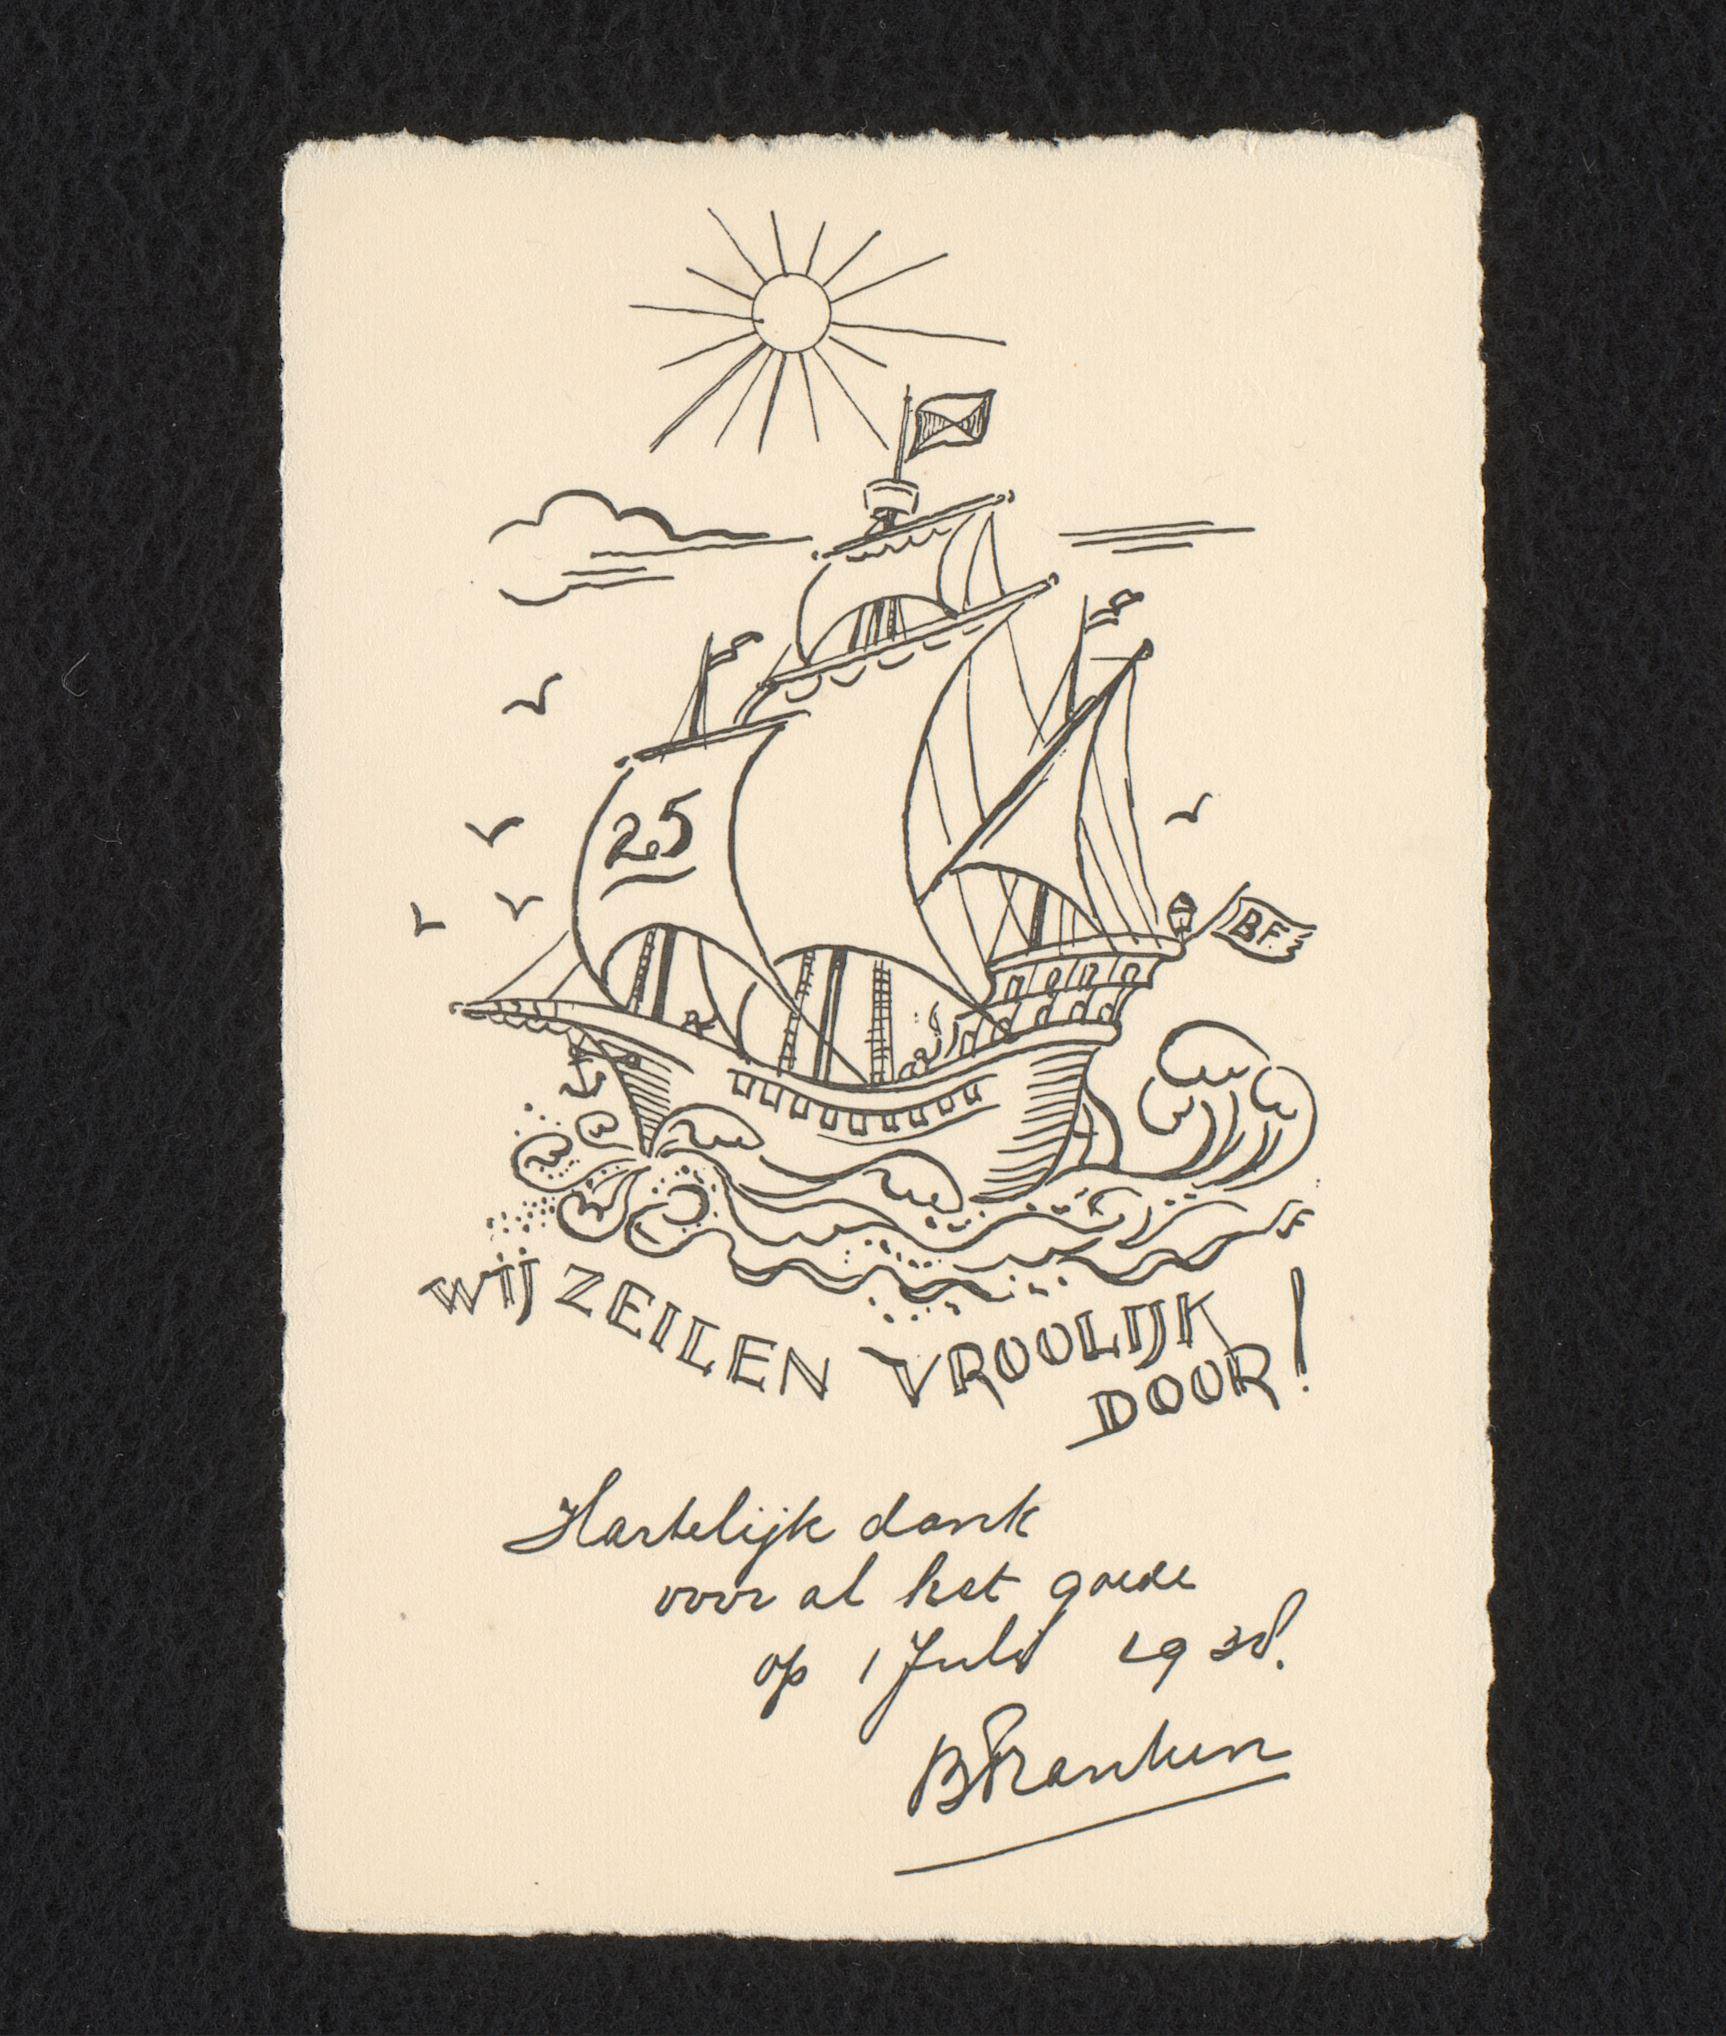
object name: acknowledgment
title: Dankbetuiging na een vijfentwintigjarig jubileum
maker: Anonymous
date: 1938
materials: paper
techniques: printing block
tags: sailing-ship, sailing-boat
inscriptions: date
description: Een zeilschip met op de fok het getal '25'. Op de vlag op de achtersteven het monogram 'BF'. Daaronder: 'Wij zeilen vroolijk door! Hartelijk dank voor al het goede op 1 Juli 1938 [handtekening]'.